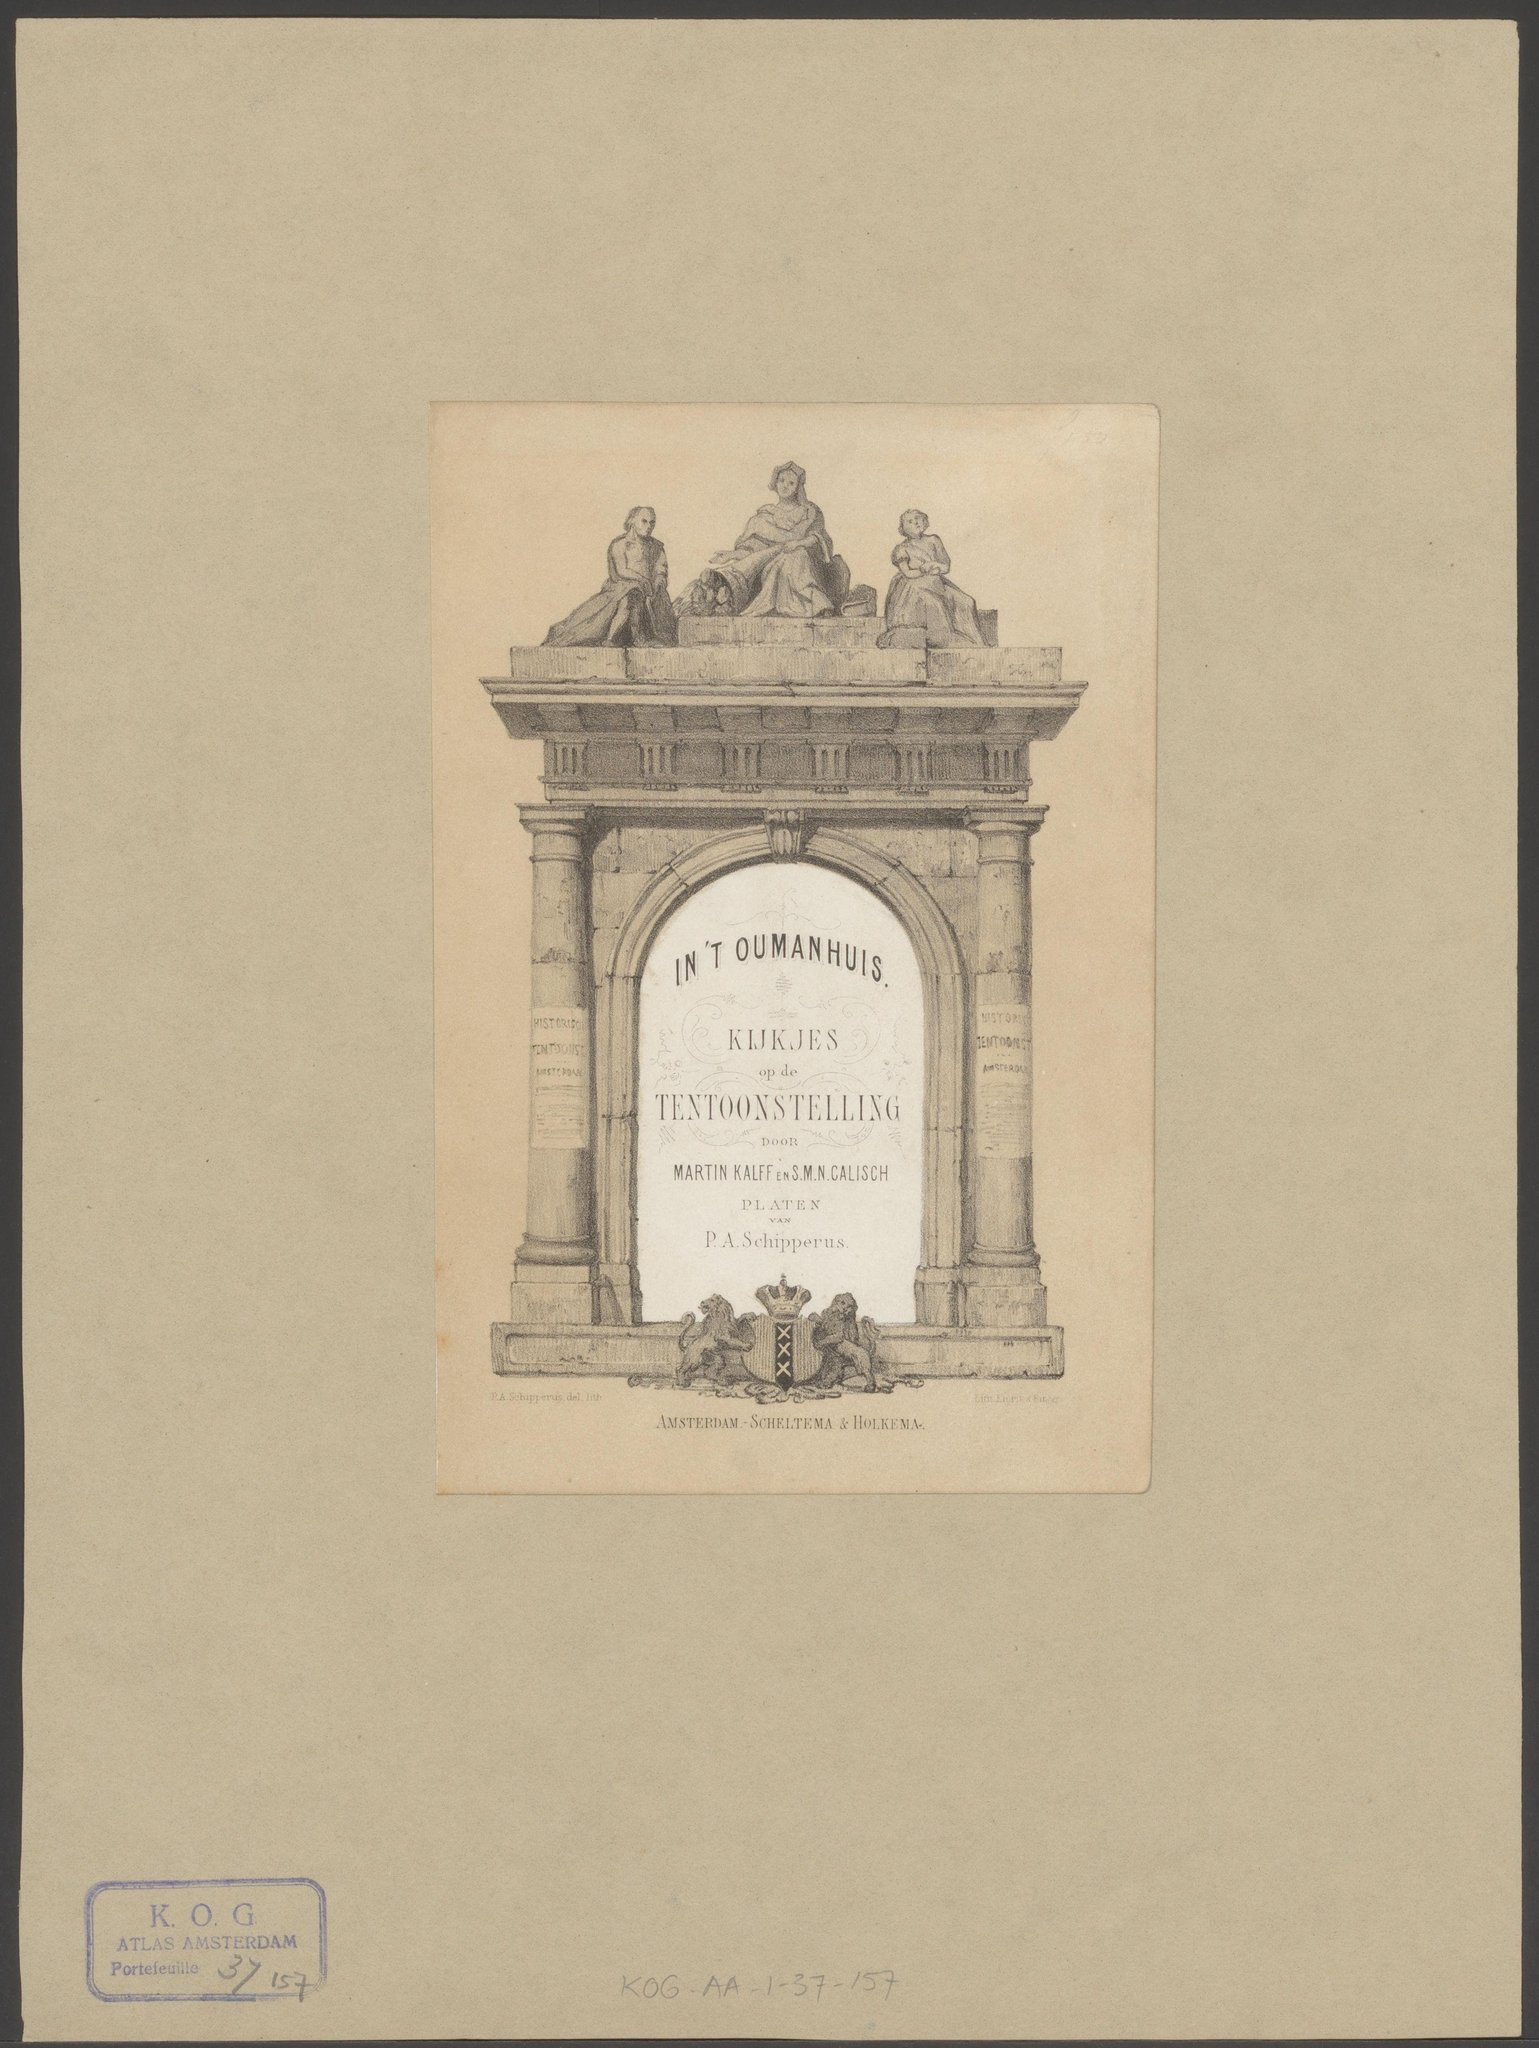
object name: titelblad, titelpagina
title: Oudemanhuispoort te Amsterdam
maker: piet schipperus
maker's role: draughtsman, print maker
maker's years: 1840-1929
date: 1876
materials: paper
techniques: tone lithography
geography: haarlem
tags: coat of arms (as symbol of the state, etc.) (+ city; municipal), gate, entrance, old-people's home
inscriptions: collector's mark: Lugt 1641b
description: Titelpagina voor: Kalff, Martin, en Salomon Martinus Nathan Calisch. In 't Oumanhuis. Kijkjes op de Tentoonstelling. Amsterdam: Scheltema & Holkema, 1876.